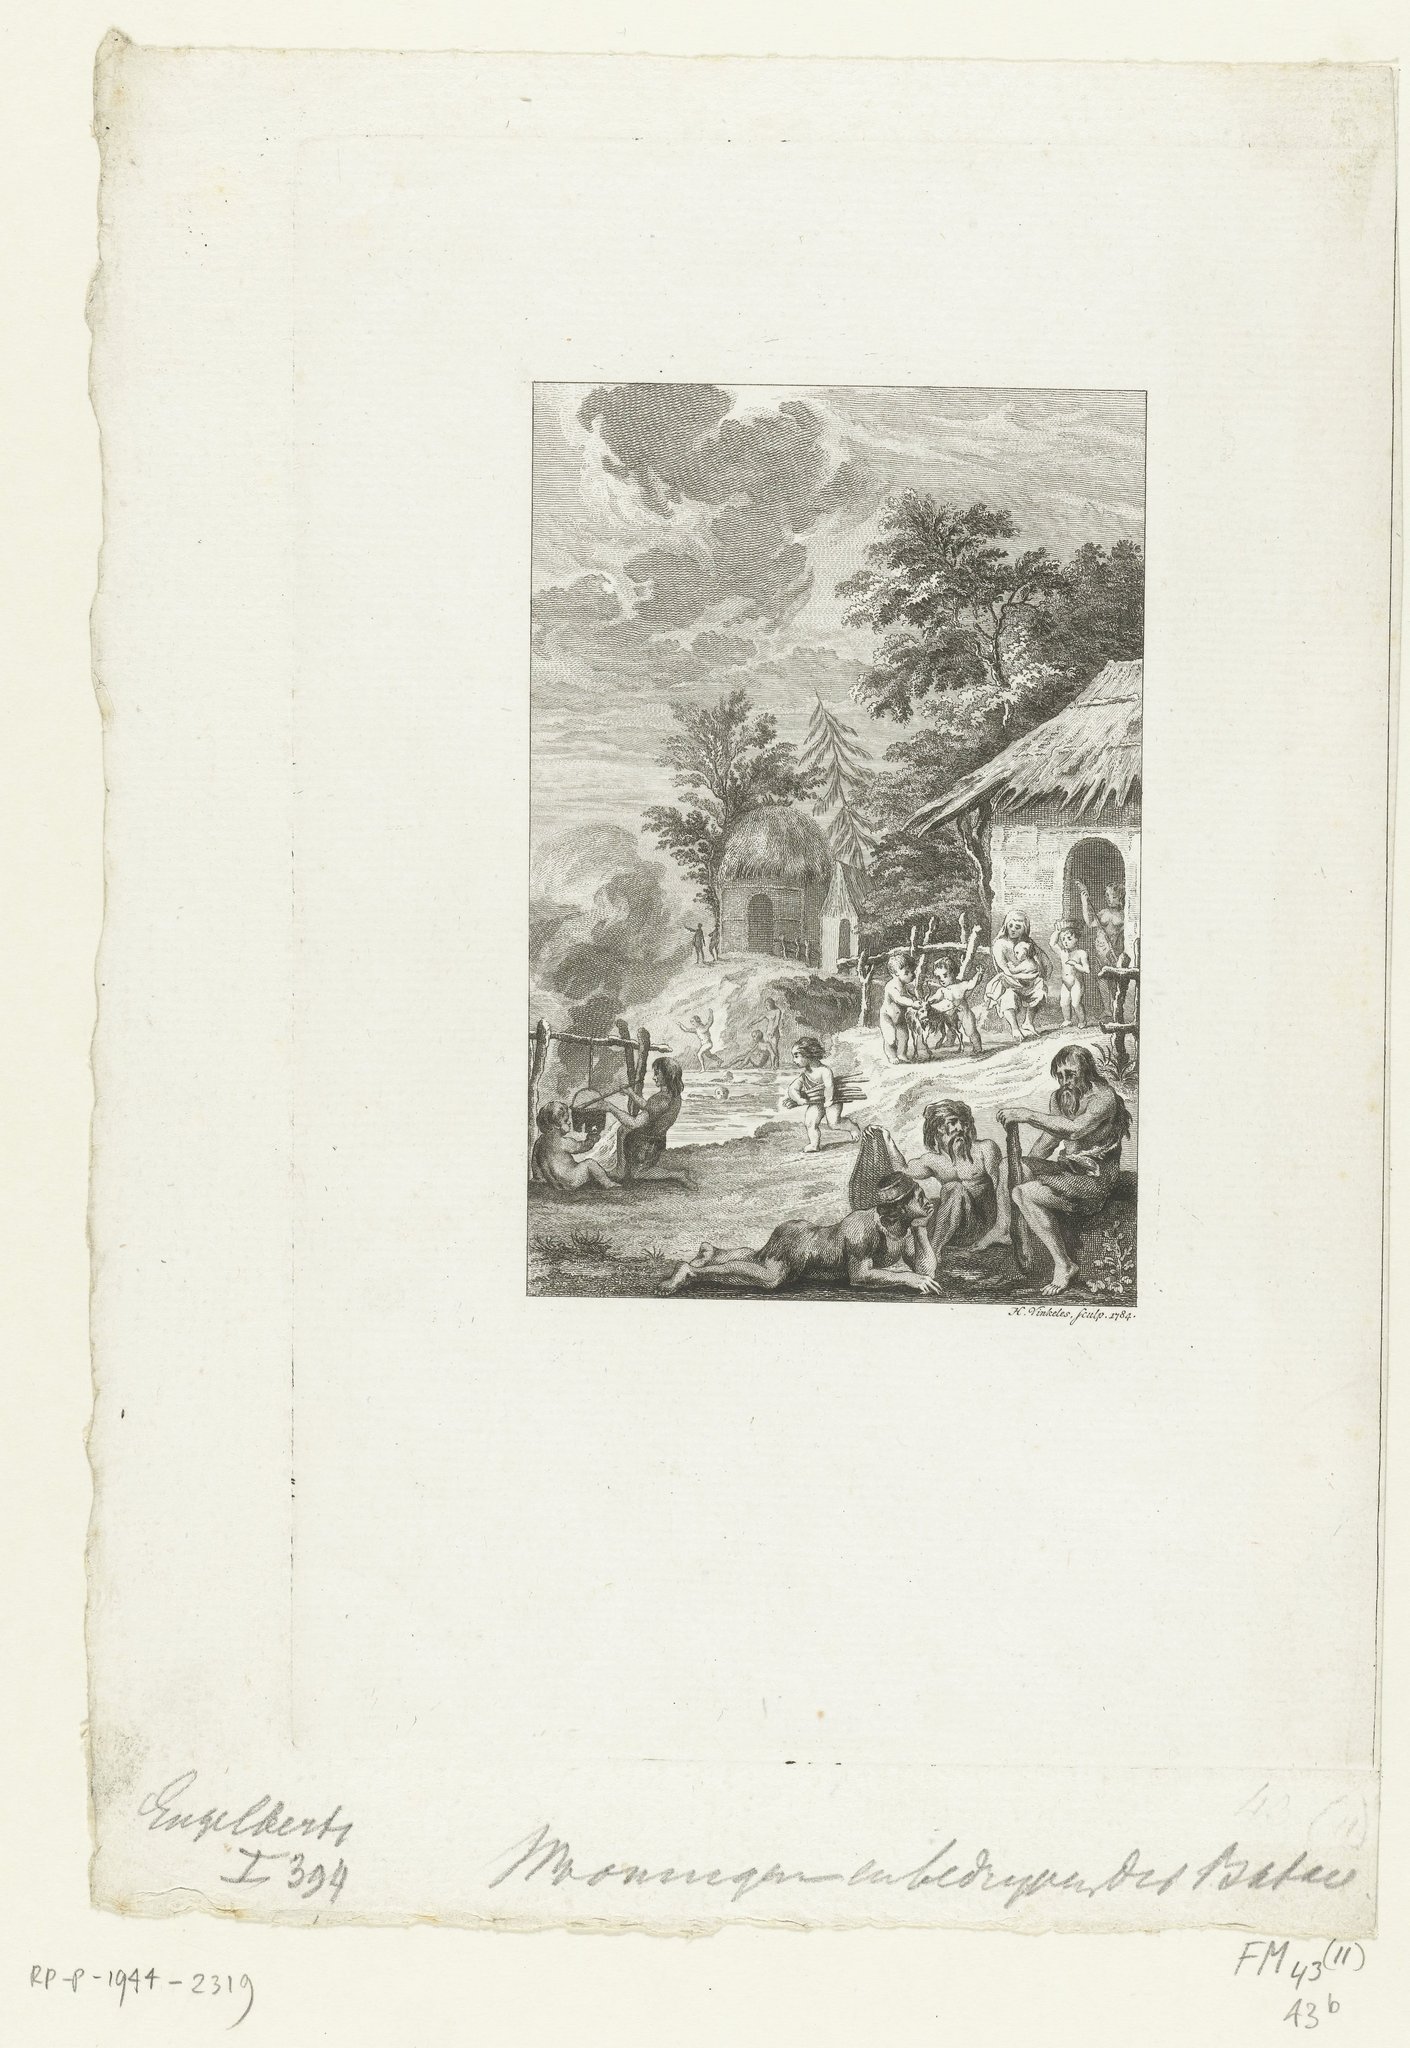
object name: print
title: Huiselijk leven van de Bataven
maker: harmanus vinkeles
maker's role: draughtsman, print maker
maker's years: 1745-1825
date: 1784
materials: paper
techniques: etching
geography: netherlands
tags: extinct, 'historical' peoples (with name), netherlands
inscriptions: date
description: Illustratie voor: E.M. Engelberts, De aloude staat en geschiedenissen der Vereenigde Nederlanden, Johannes Allart, Amsterdam 1784-1799, dl. I, p. 394. Staat vóór de letter.